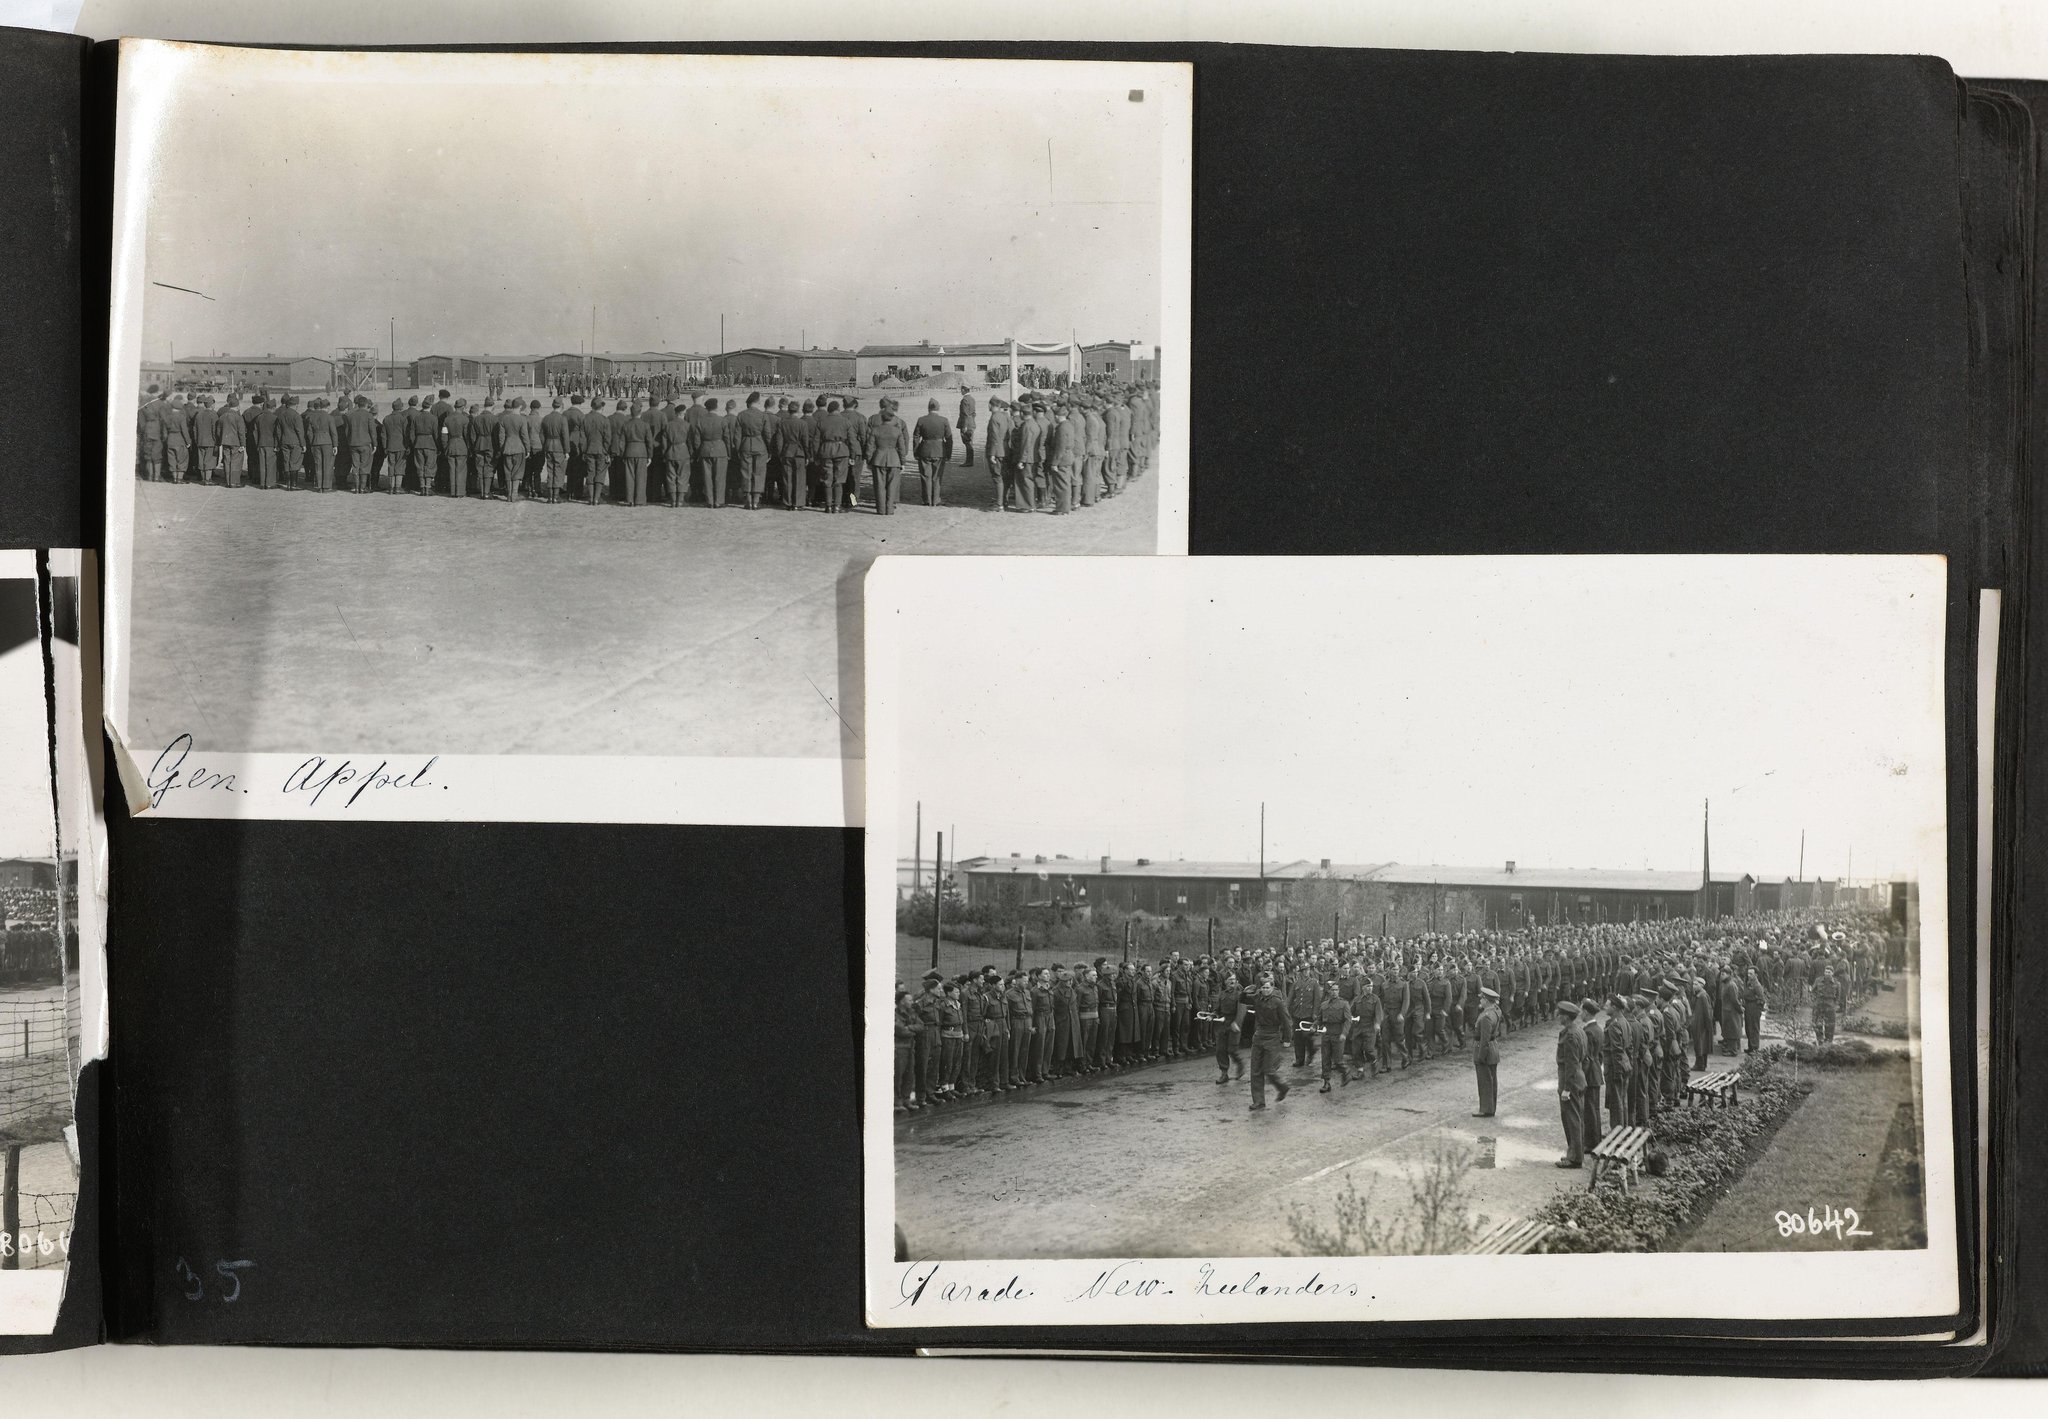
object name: album leaf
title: Gen. Appel / Parade New-Zeelanders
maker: dick w.b. van maarseveen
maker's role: fotograaf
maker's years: 1905-1990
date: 1943-1945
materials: cardboard, photographic support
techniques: gelatin silver print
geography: muhlberg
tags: the hague, dick w.b. van maarseveen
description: Albumblad met twee foto’s: generaal appel en een parade van de Nieuw Zeelanders. Onderdeel van een fotoalbum met foto's door Dick van Maarseveen van het krijgsgevangenenkamp Stalag IV B in Mühlberg in de periode 1943-1945.